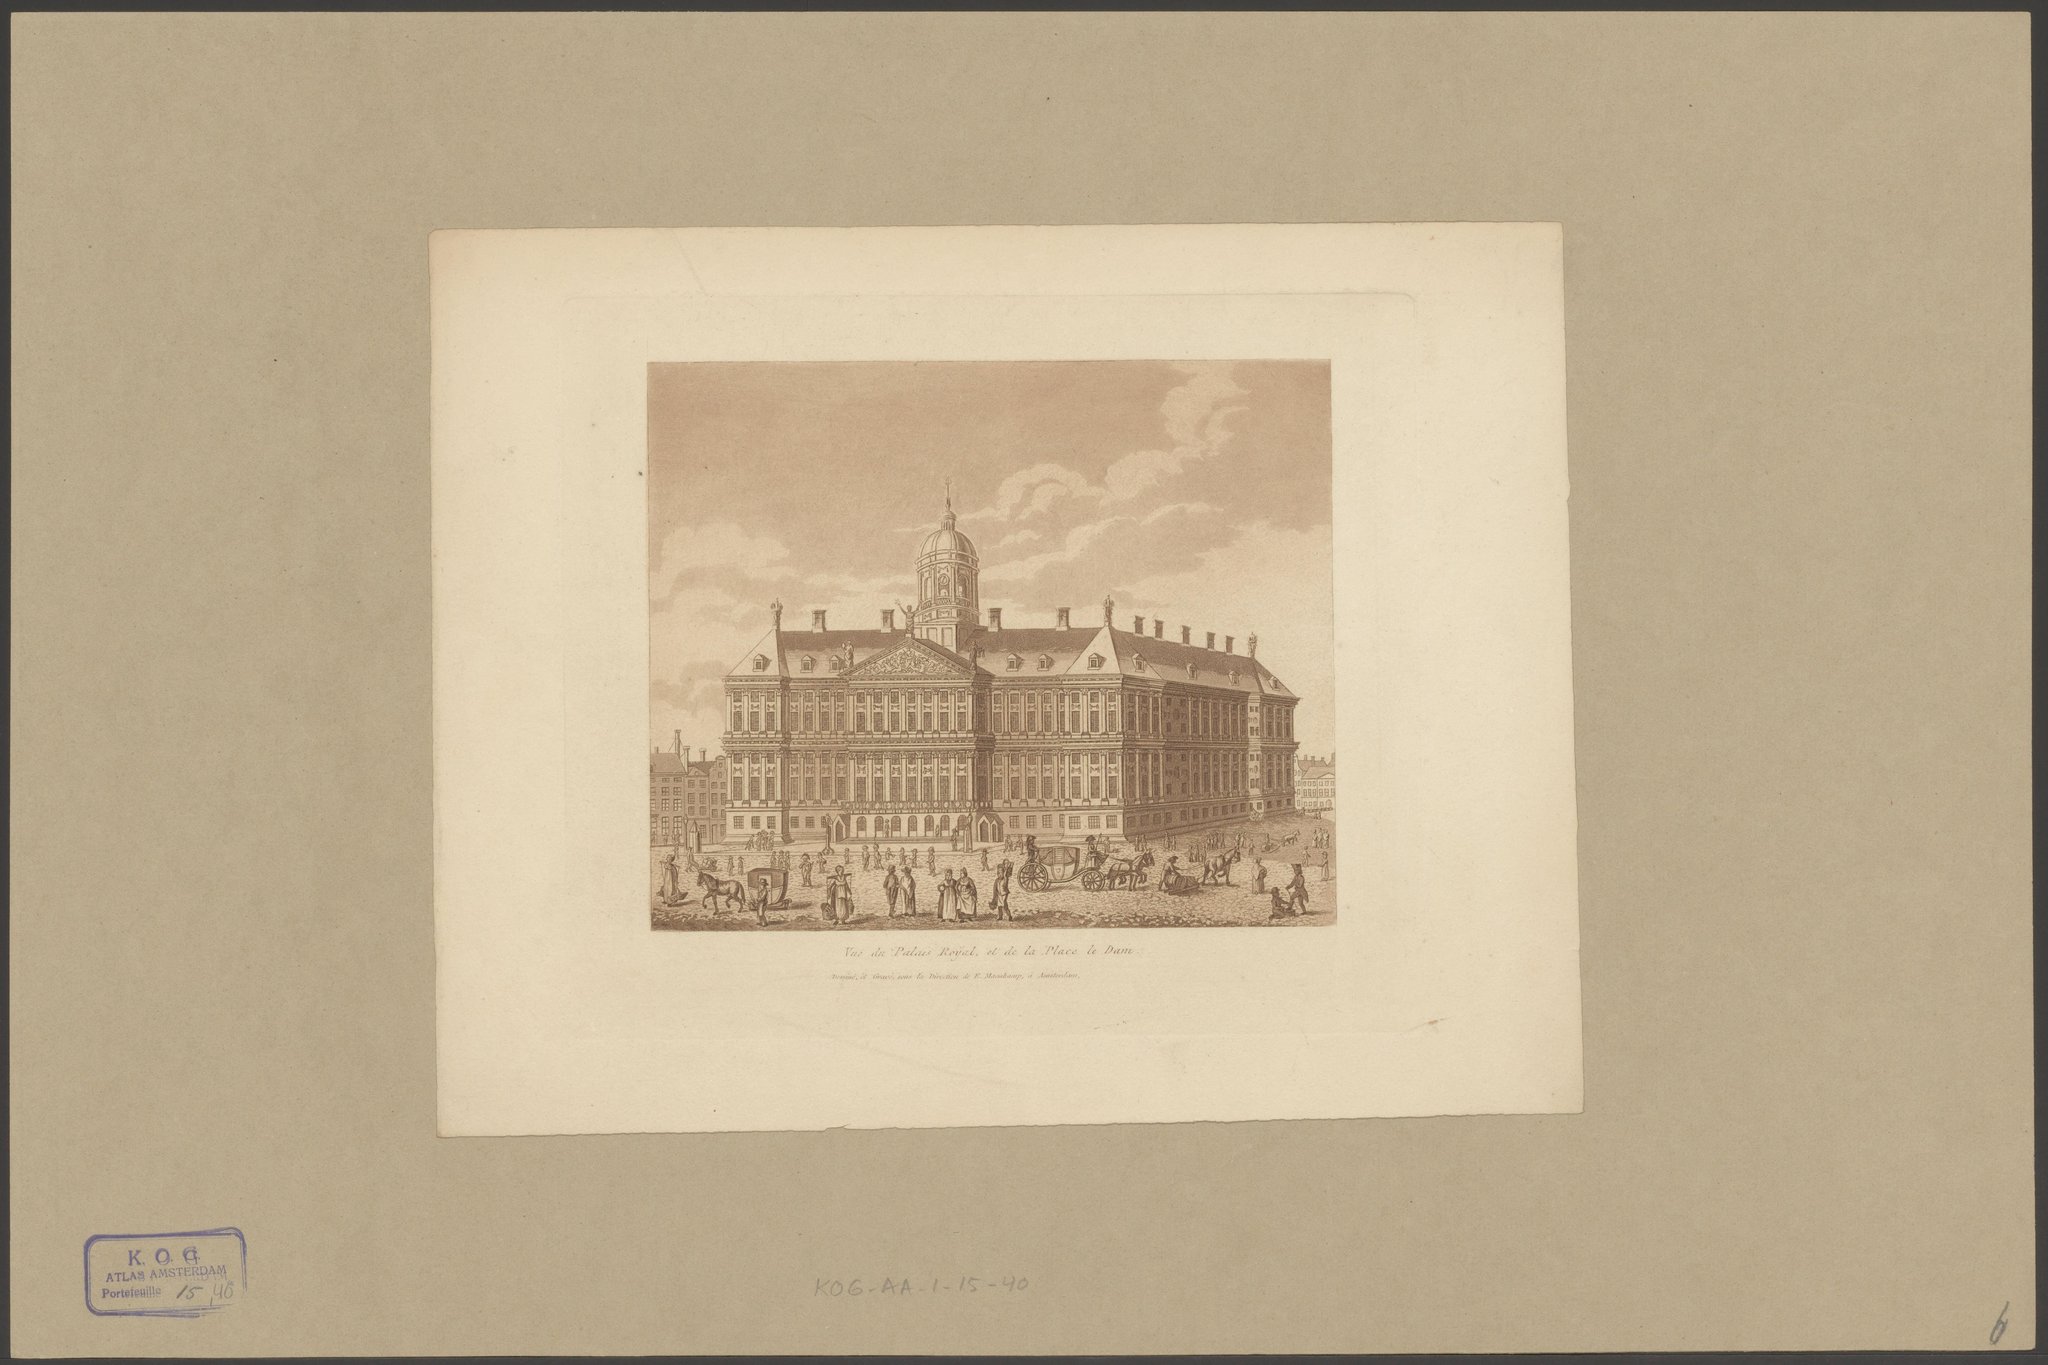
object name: print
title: Vue du Palais Royal, et de la Place le Dam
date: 1787-1834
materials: paper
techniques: aquatint, etching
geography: amsterdam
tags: square, place, circus, etc., city-view in general; 'veduta', townhall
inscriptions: collector's mark: ‘15,40’ Lugt 1641b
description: Onderwerpsrubriek binnen de Atlas Amsterdam: Nieuwe Stadhuis, als Paleis, op de Dam, van Buiten.